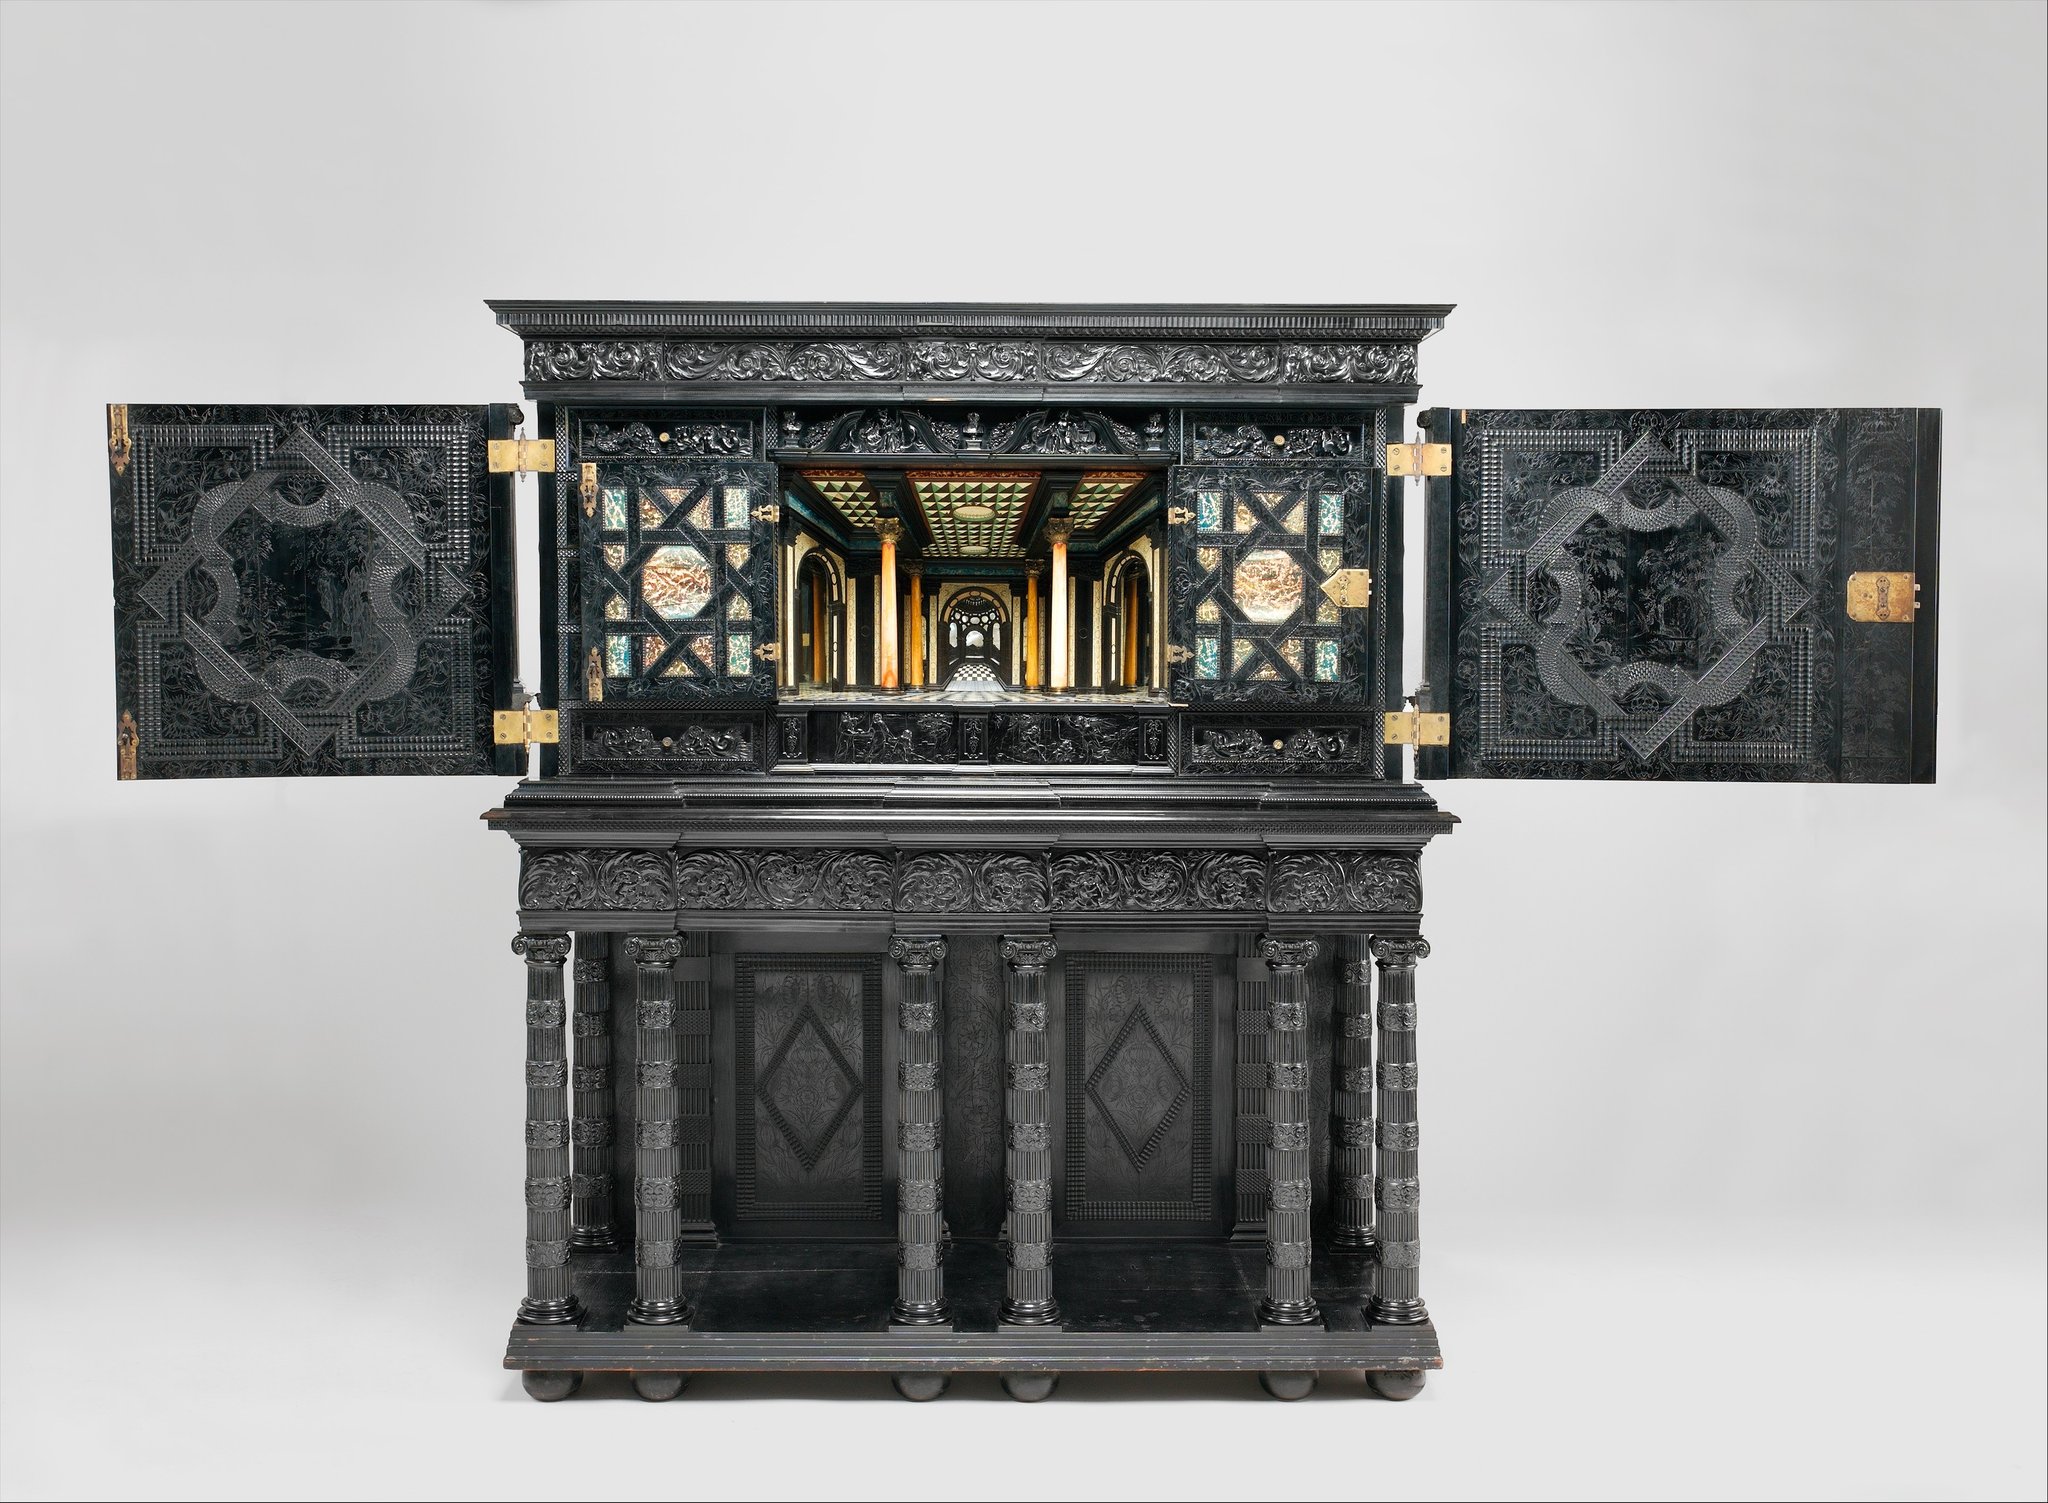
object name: cabinet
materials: bone, wood, gilt bronze, iron, ivory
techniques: stain, veneering